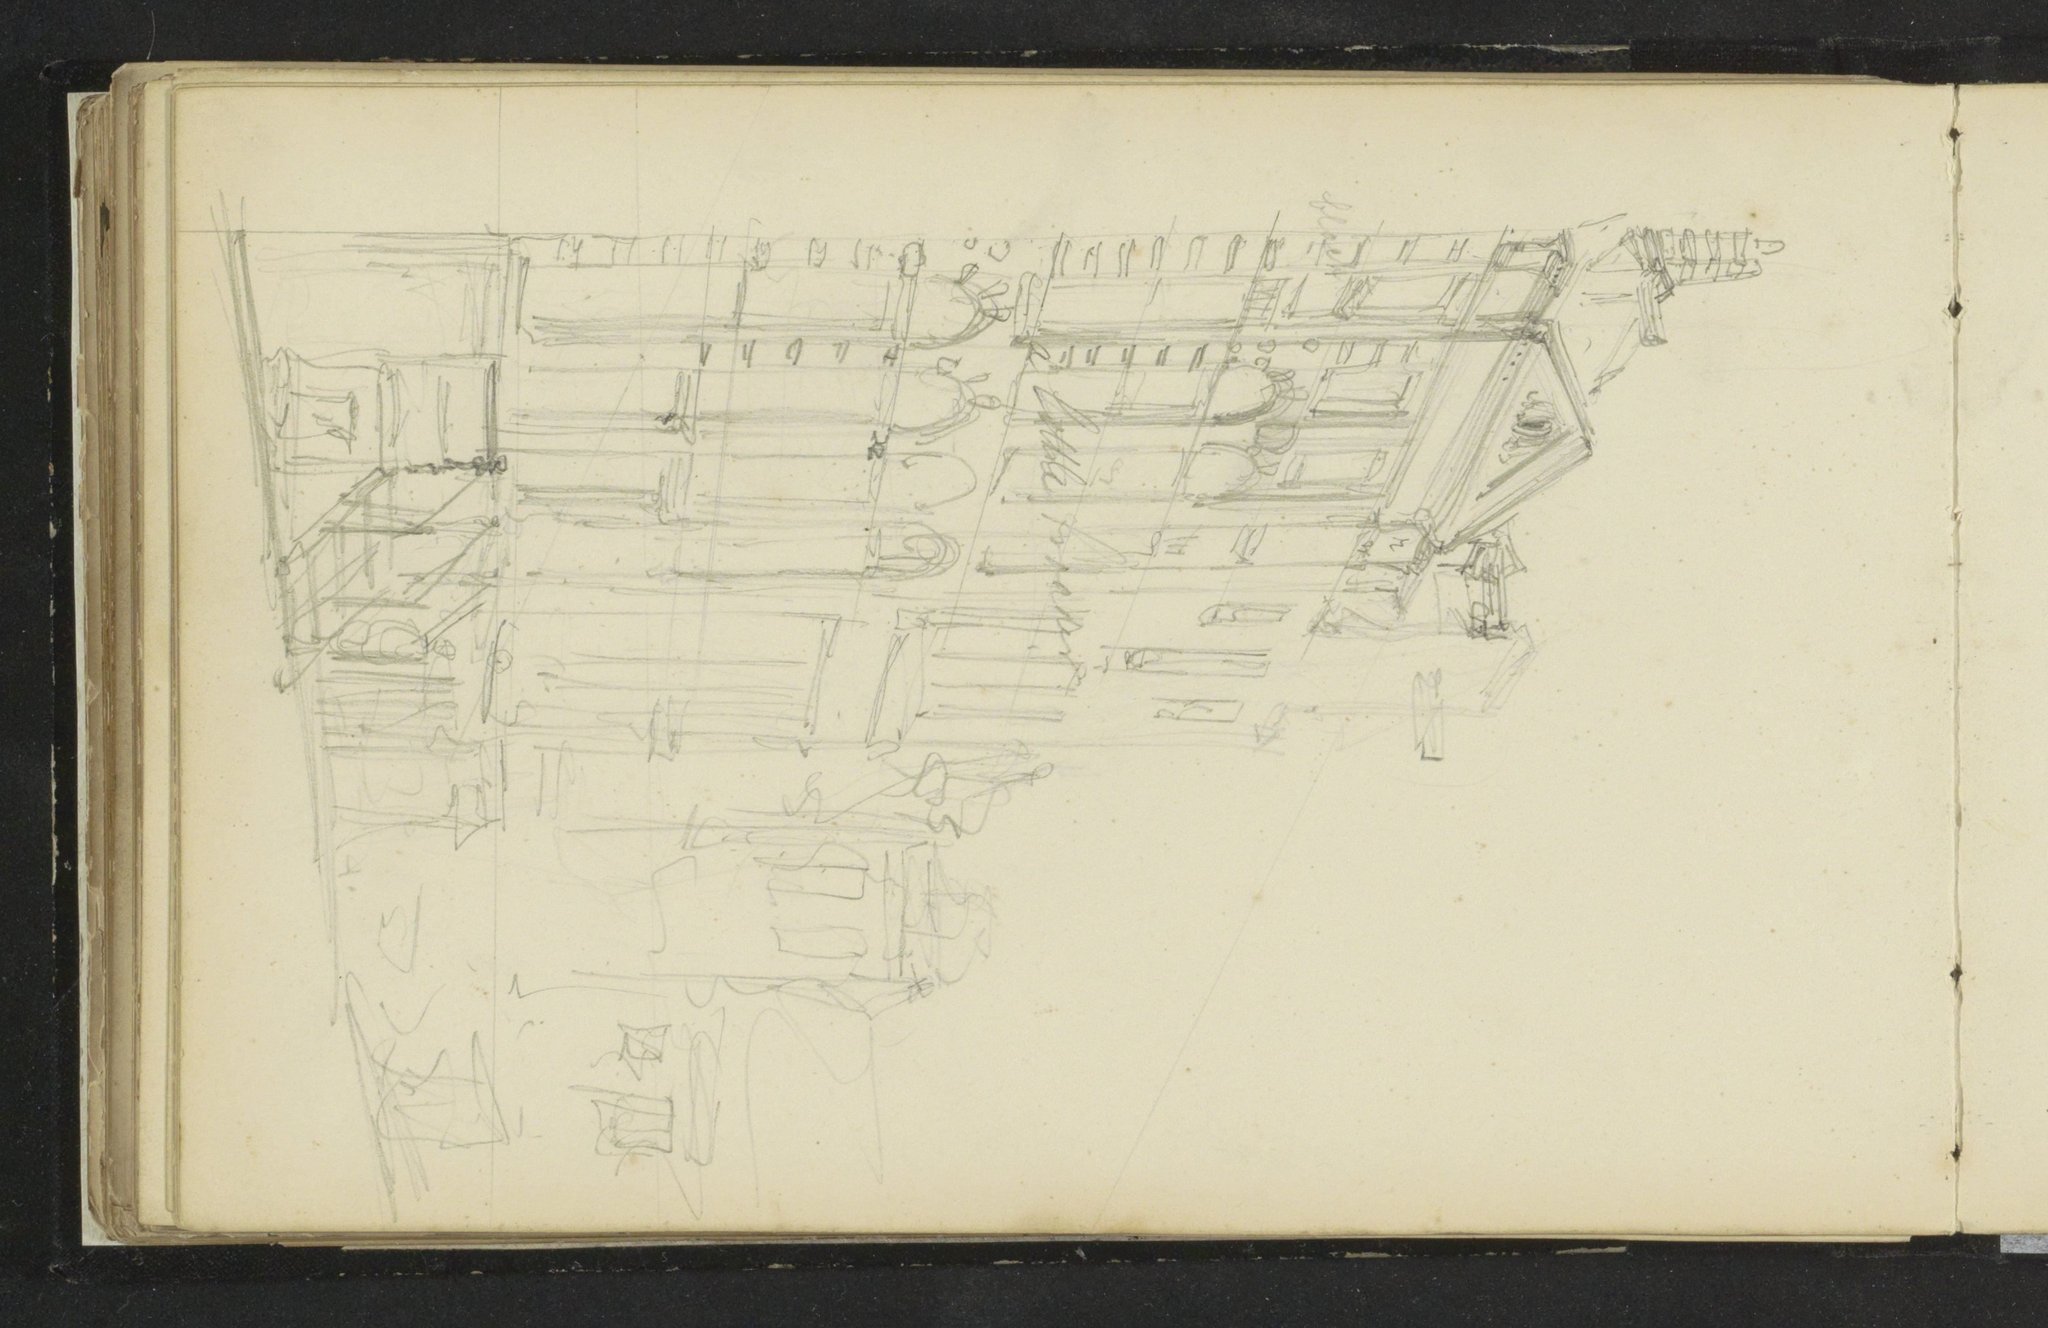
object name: sketchbook leaf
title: Gezicht op het Rembrandthuis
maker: cornelis springer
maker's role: draughtsman, painter, print maker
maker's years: 1817-1891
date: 1846-1882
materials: paper, pencil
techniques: stumping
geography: amsterdam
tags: urban housing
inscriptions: annotation: ‘a little [...]’, : ‘black[?]’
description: Gezicht op het Rembrandthuis. Blad 81 verso uit een schetsboek met 91 bladen.